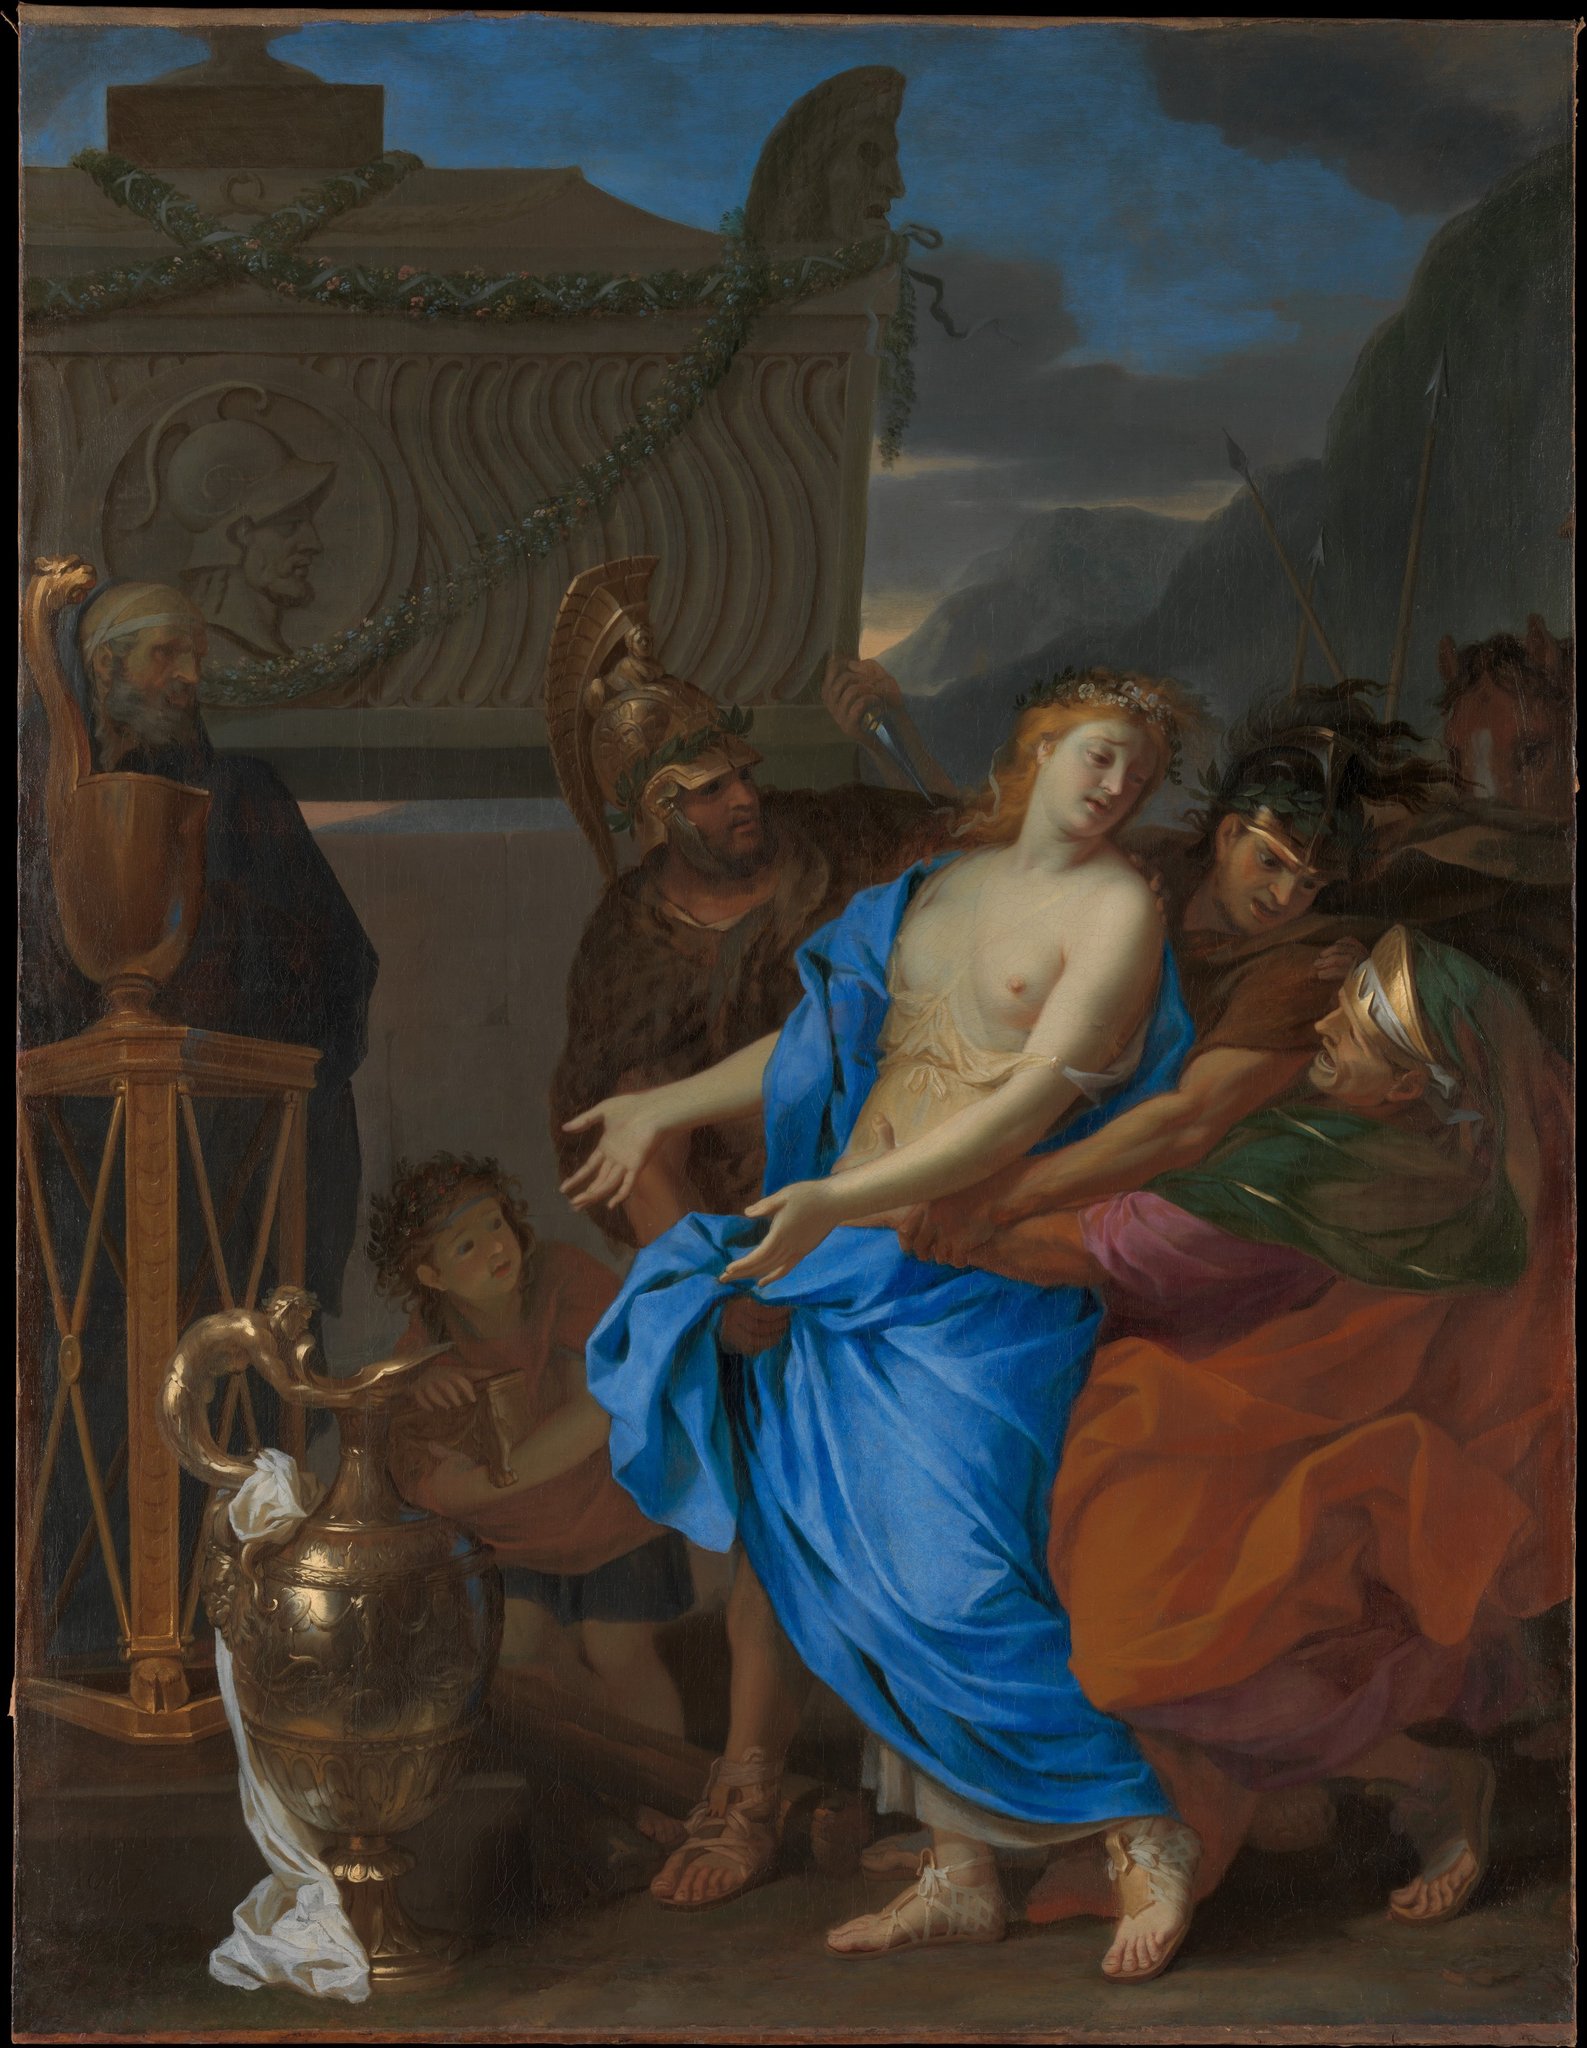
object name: painting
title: The Sacrifice of Polyxena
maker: charles le brun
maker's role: artist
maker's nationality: french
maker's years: 1619-1690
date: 1647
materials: canvas, oil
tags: soldiers,children,men,women